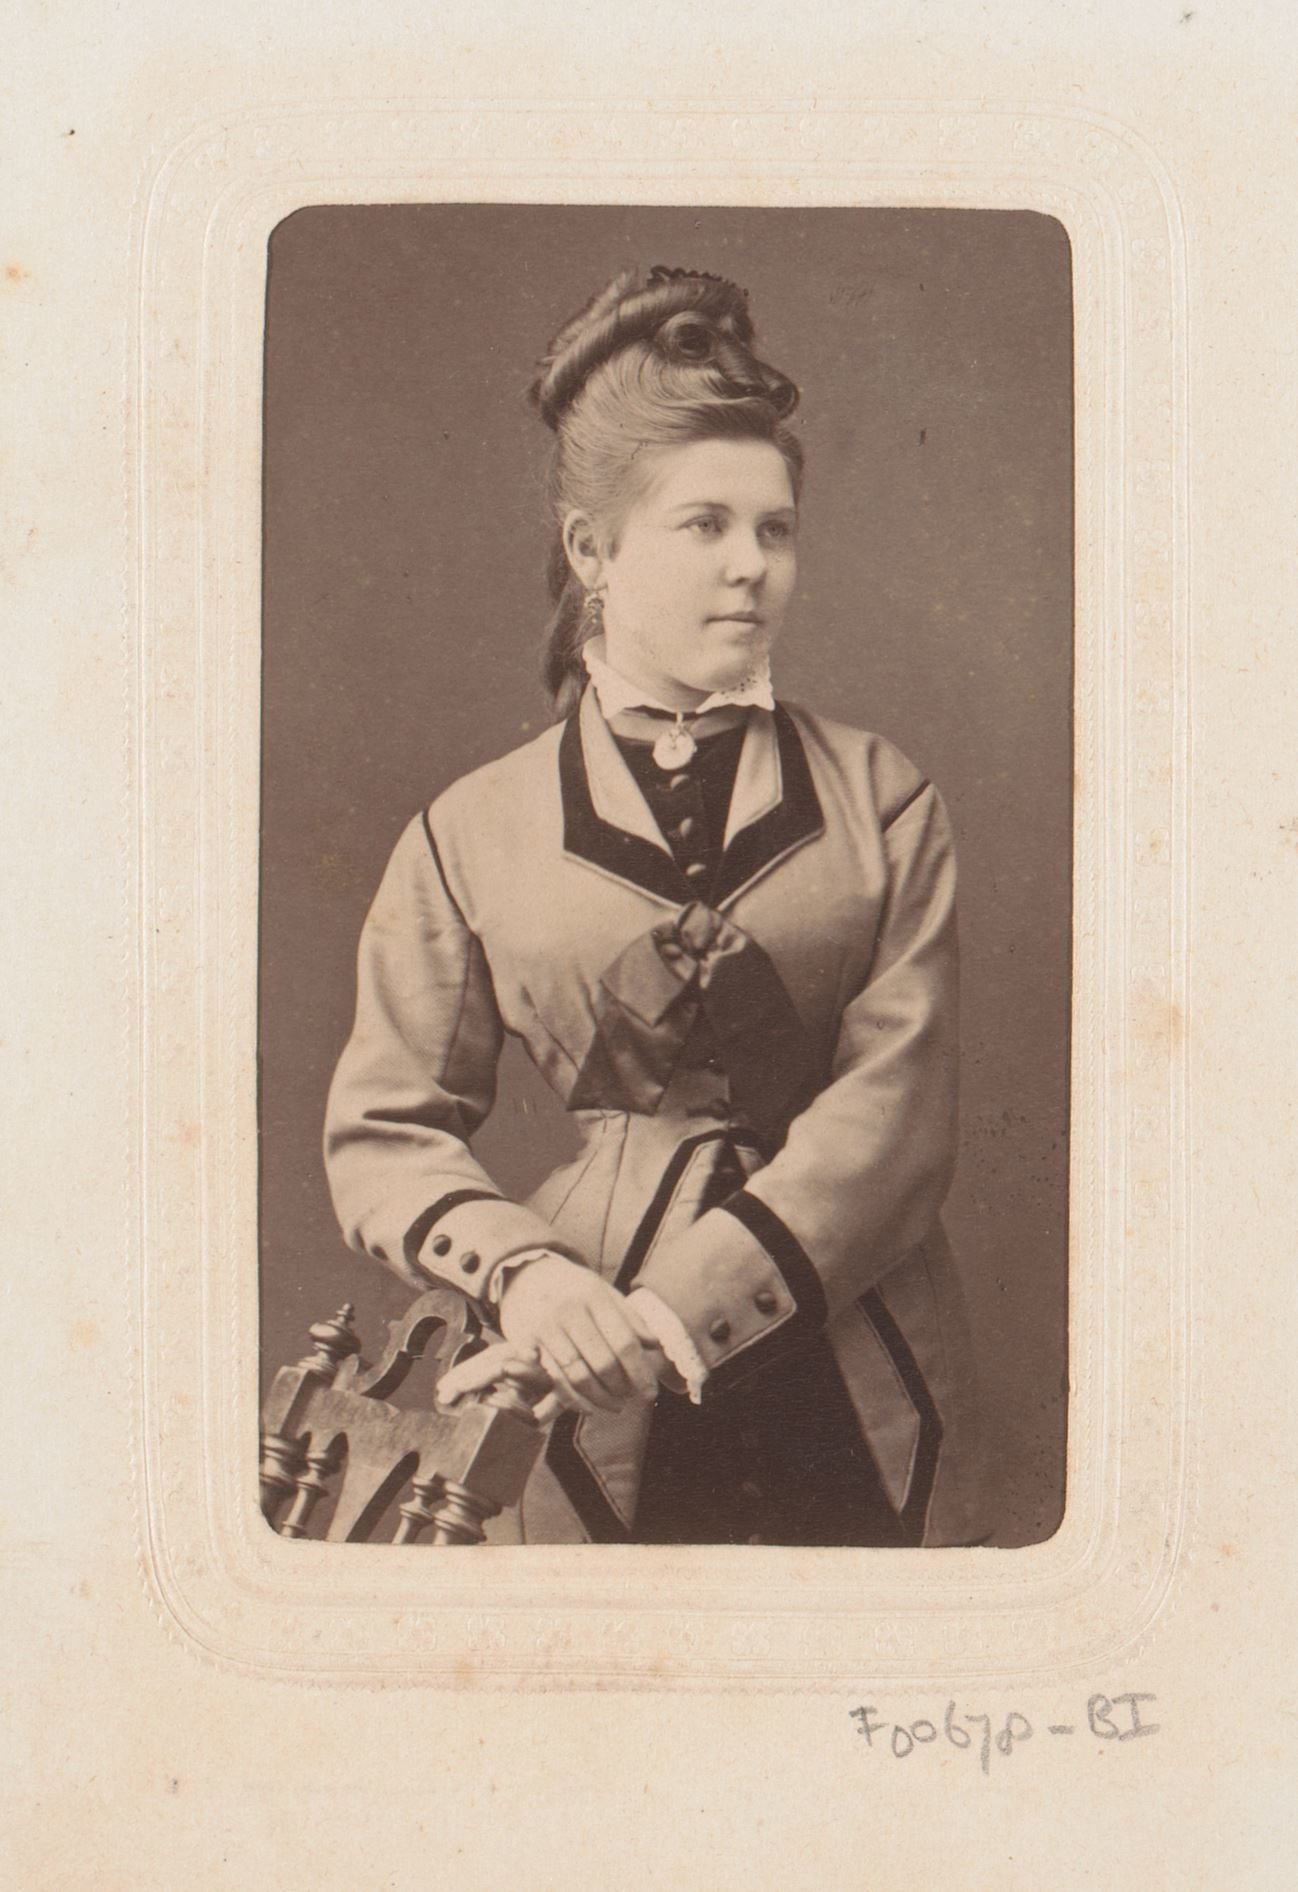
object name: album leaf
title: Portret van een staande vrouw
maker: m. brodsky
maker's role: fotograaf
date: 1870-1880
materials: cardboard, photographic support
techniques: albumen print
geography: esztergom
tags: historical persons - bb - woman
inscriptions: inscription: ‘Brodsky, M./ fényképész/ Esztergomban/ anyàri szinhàzépüllet/ mellet/ Photograph/ Gran/ neben dem Theater-Gebäude (...)’